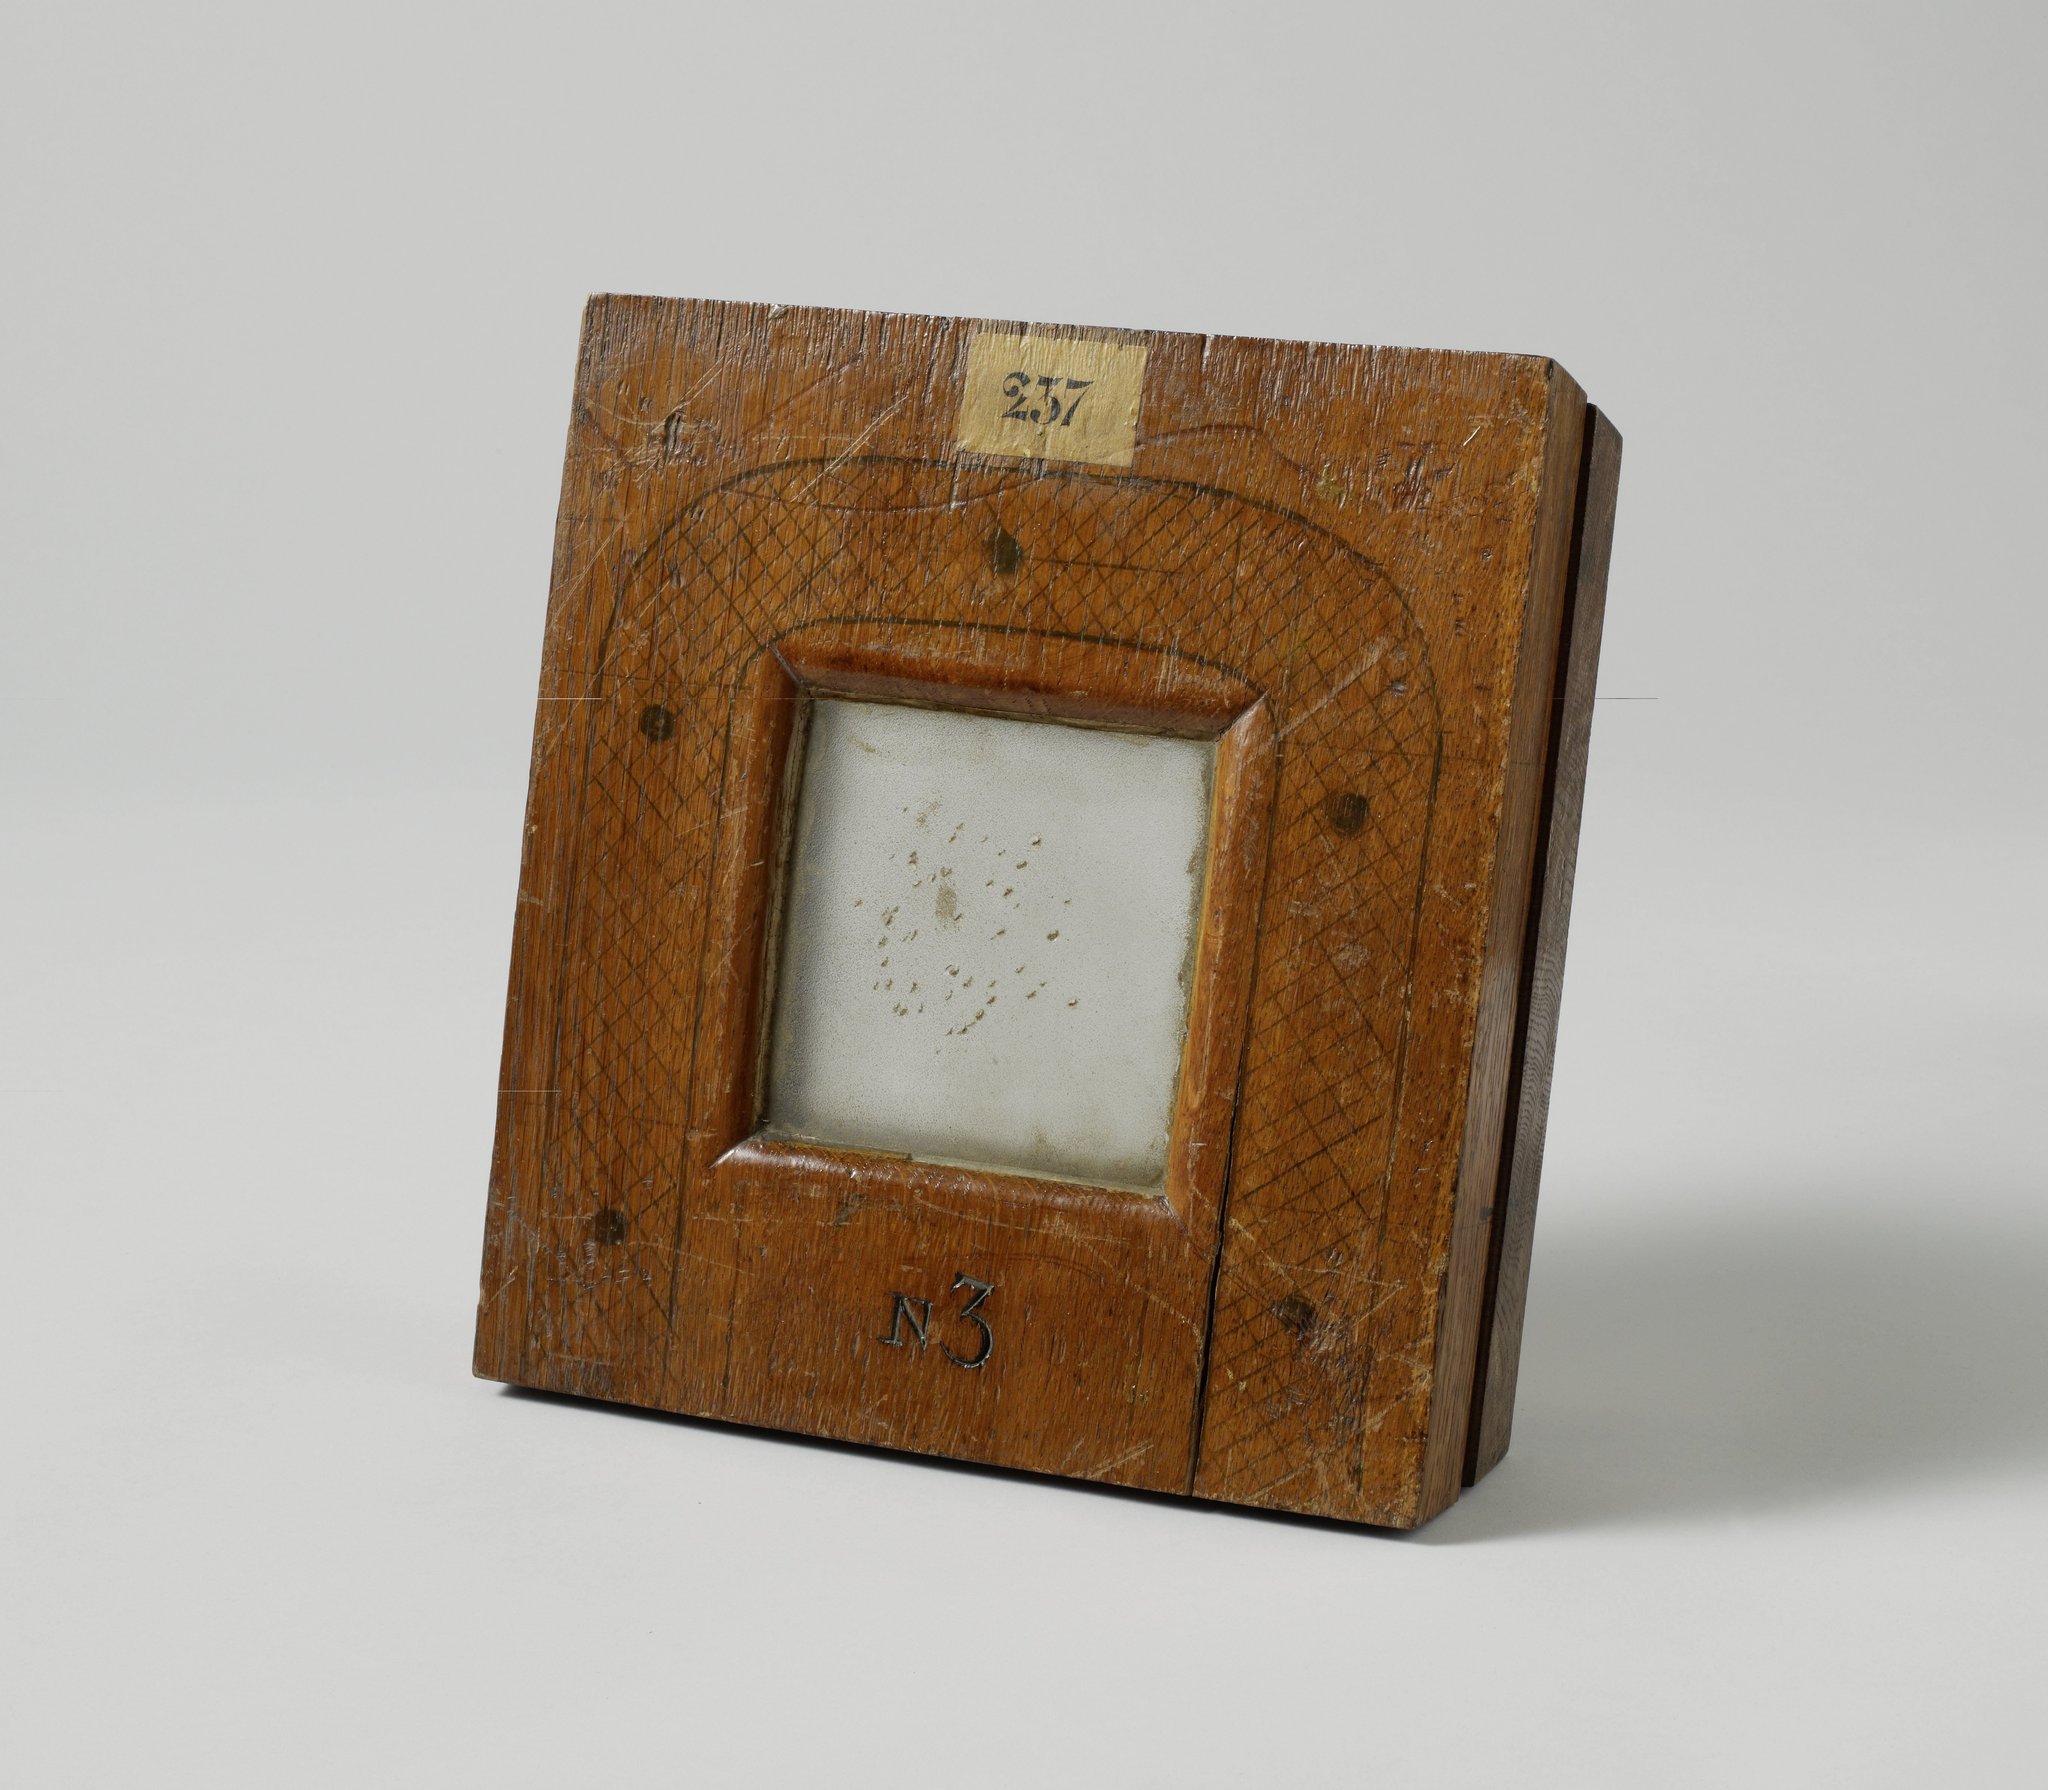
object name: portlight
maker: Anonymous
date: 1832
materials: cardboard, copper, glass, iron, putty, wood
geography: netherlands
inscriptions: label, top: ‘237’ former inventory label, inscription, on the side: ‘P’, inscription, below the glass: ‘N3’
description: Deze modellen MC-236 t/m 238 vormen samen waarschijnlijk de serie modellen die besteld werden op grond van het voorstel van P. Schuijt, P. Glavimans Jz. en C. Soetermeer van 1832 voor glazen patrijspoorten in een bovenhoek van de geschutpoorten van linieschepen. Hun voorstel was geïnspireerd op het voorbeeld van de Waterloo (zie NG-MC-235) en volgde op hun beoordeling van de twee lichtglazen van P. Schuijt jr. (NG-MC-238-1 en NG-MC-238-2). Het glas van NG-MC-237-1 is waarschijnlijk identiek aan dat door P. Schuijt jr. voorgesteld (NG-MC-238-2).